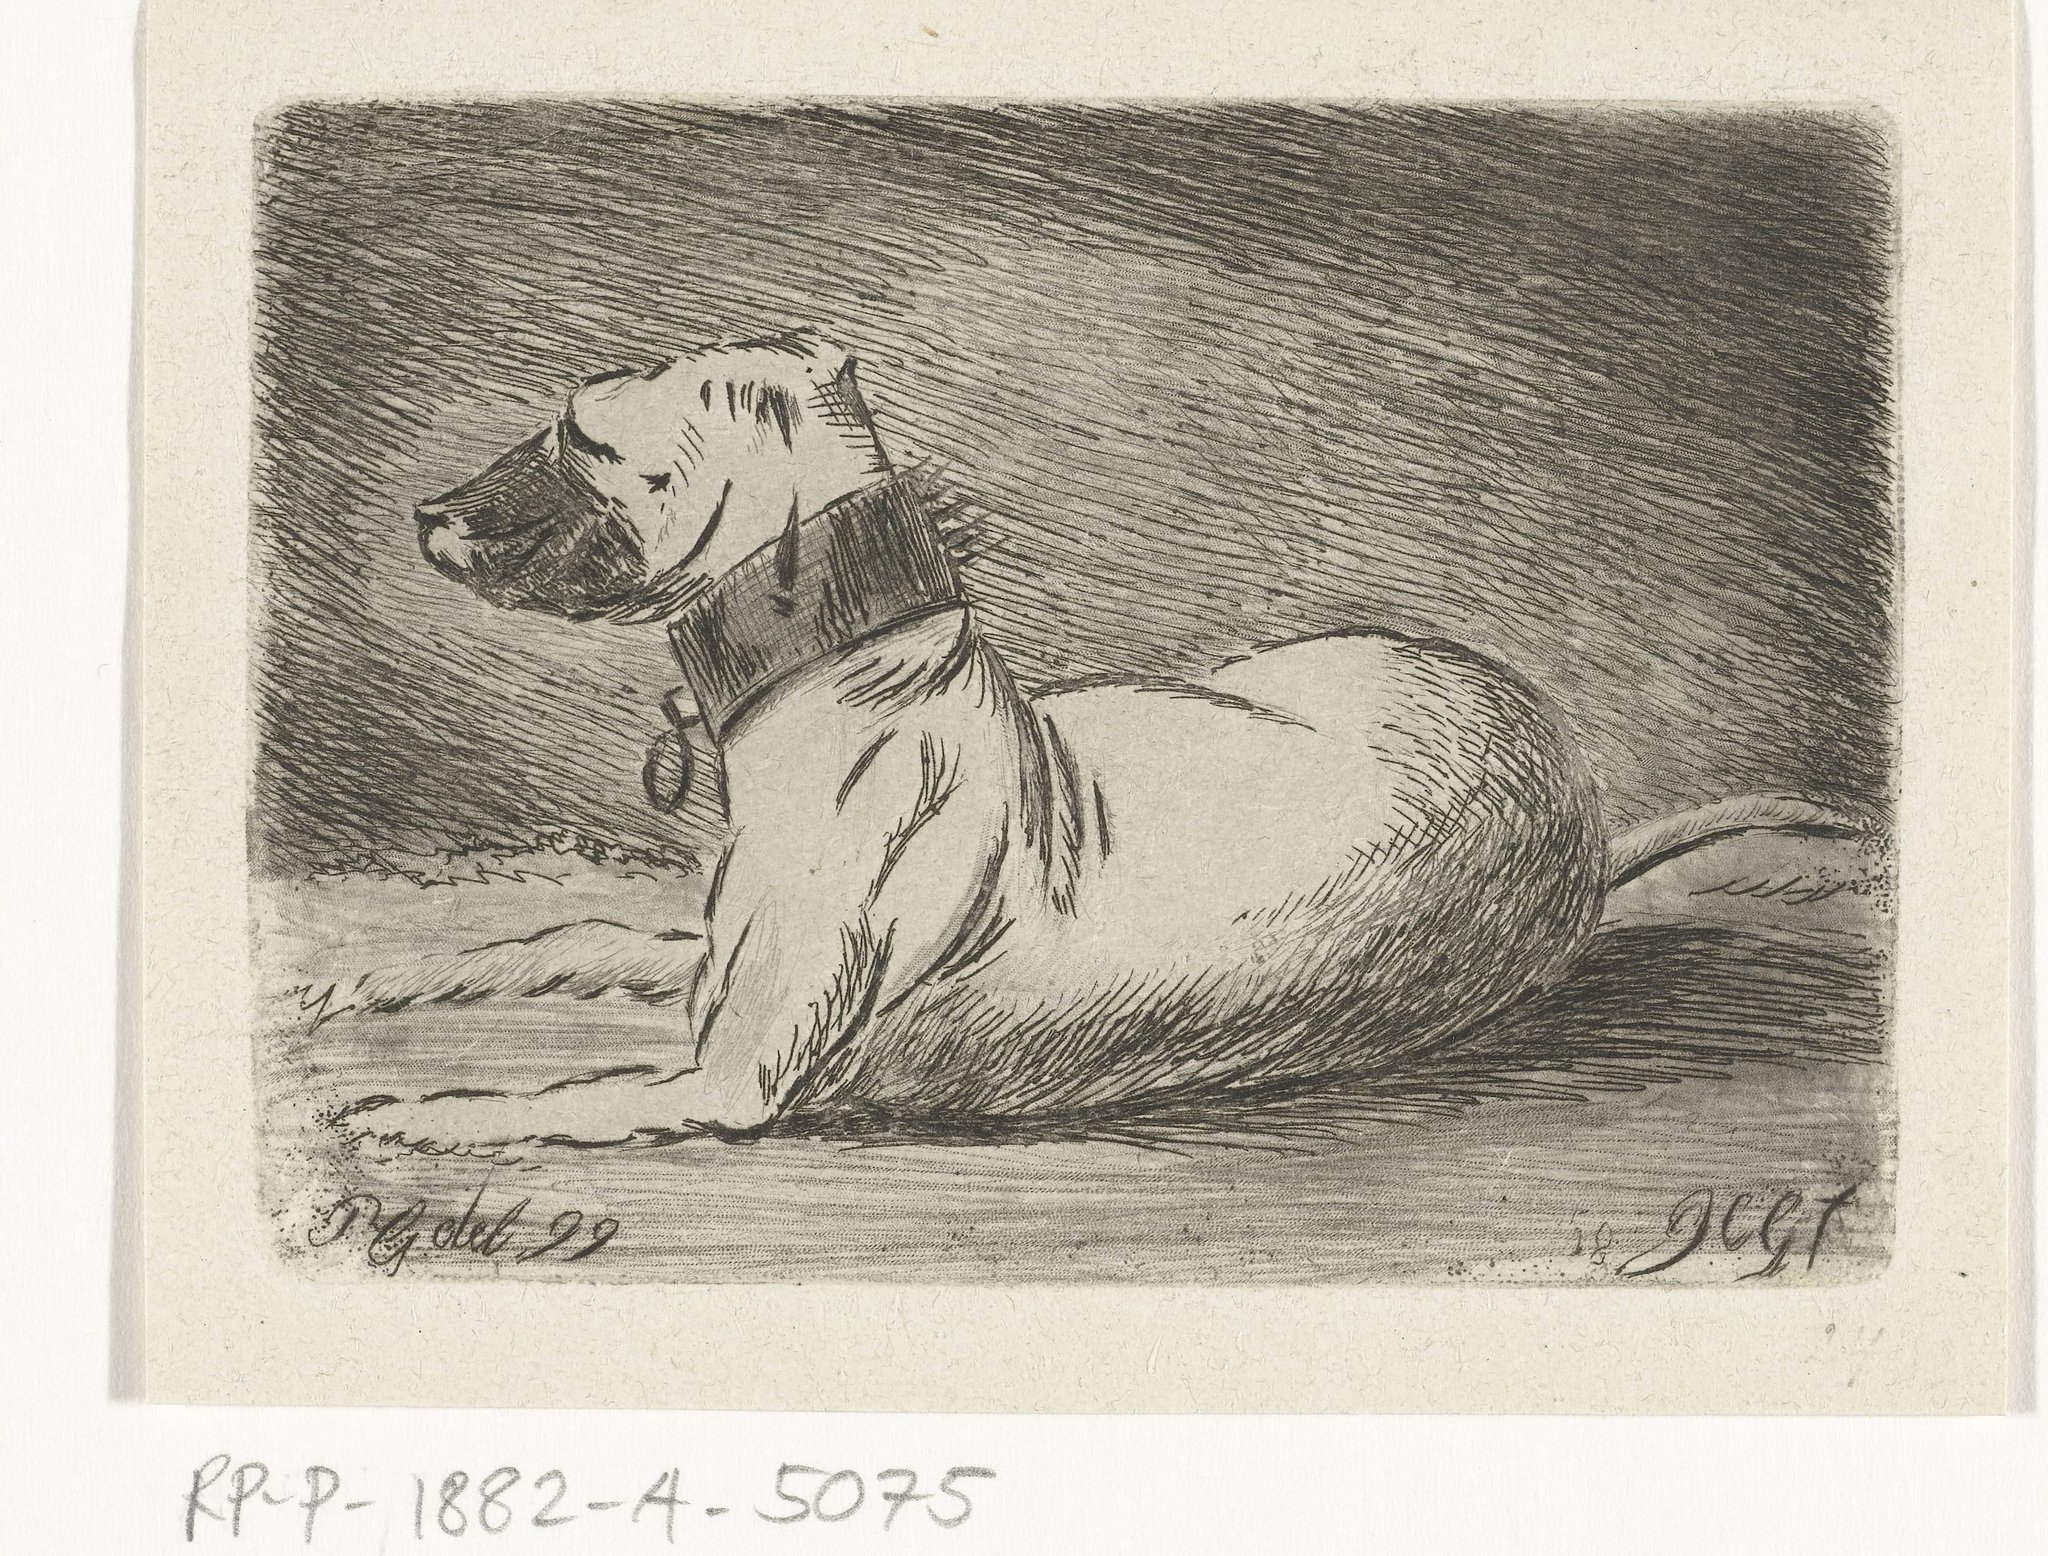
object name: print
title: Liggende hond met halsband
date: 1858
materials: paper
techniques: etching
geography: netherlands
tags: dog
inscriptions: collector's mark: Lugt 2228